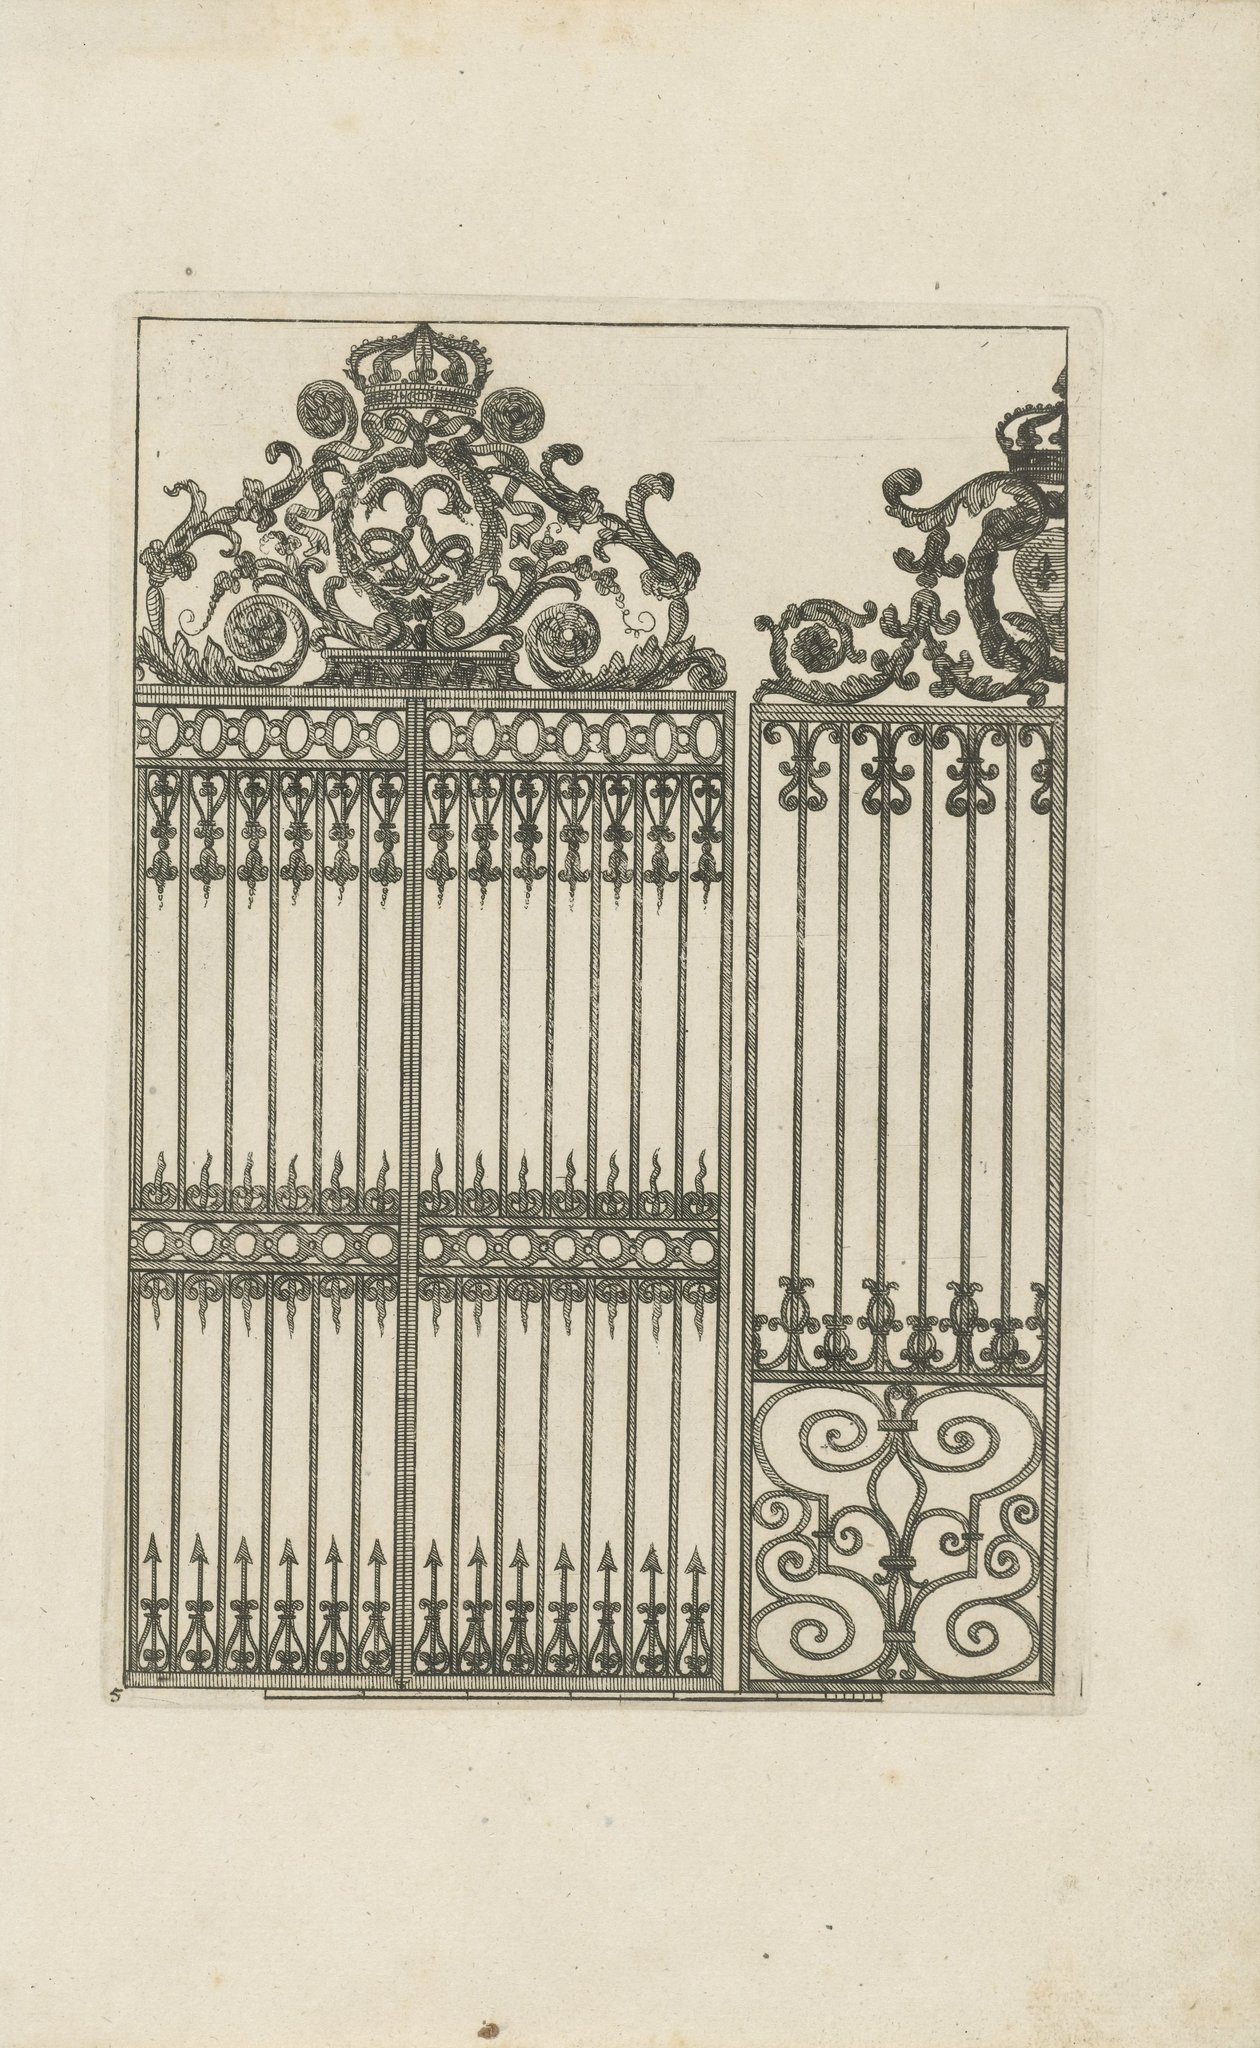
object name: ornament print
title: Hek met variant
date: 1726-1750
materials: paper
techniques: etching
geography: france